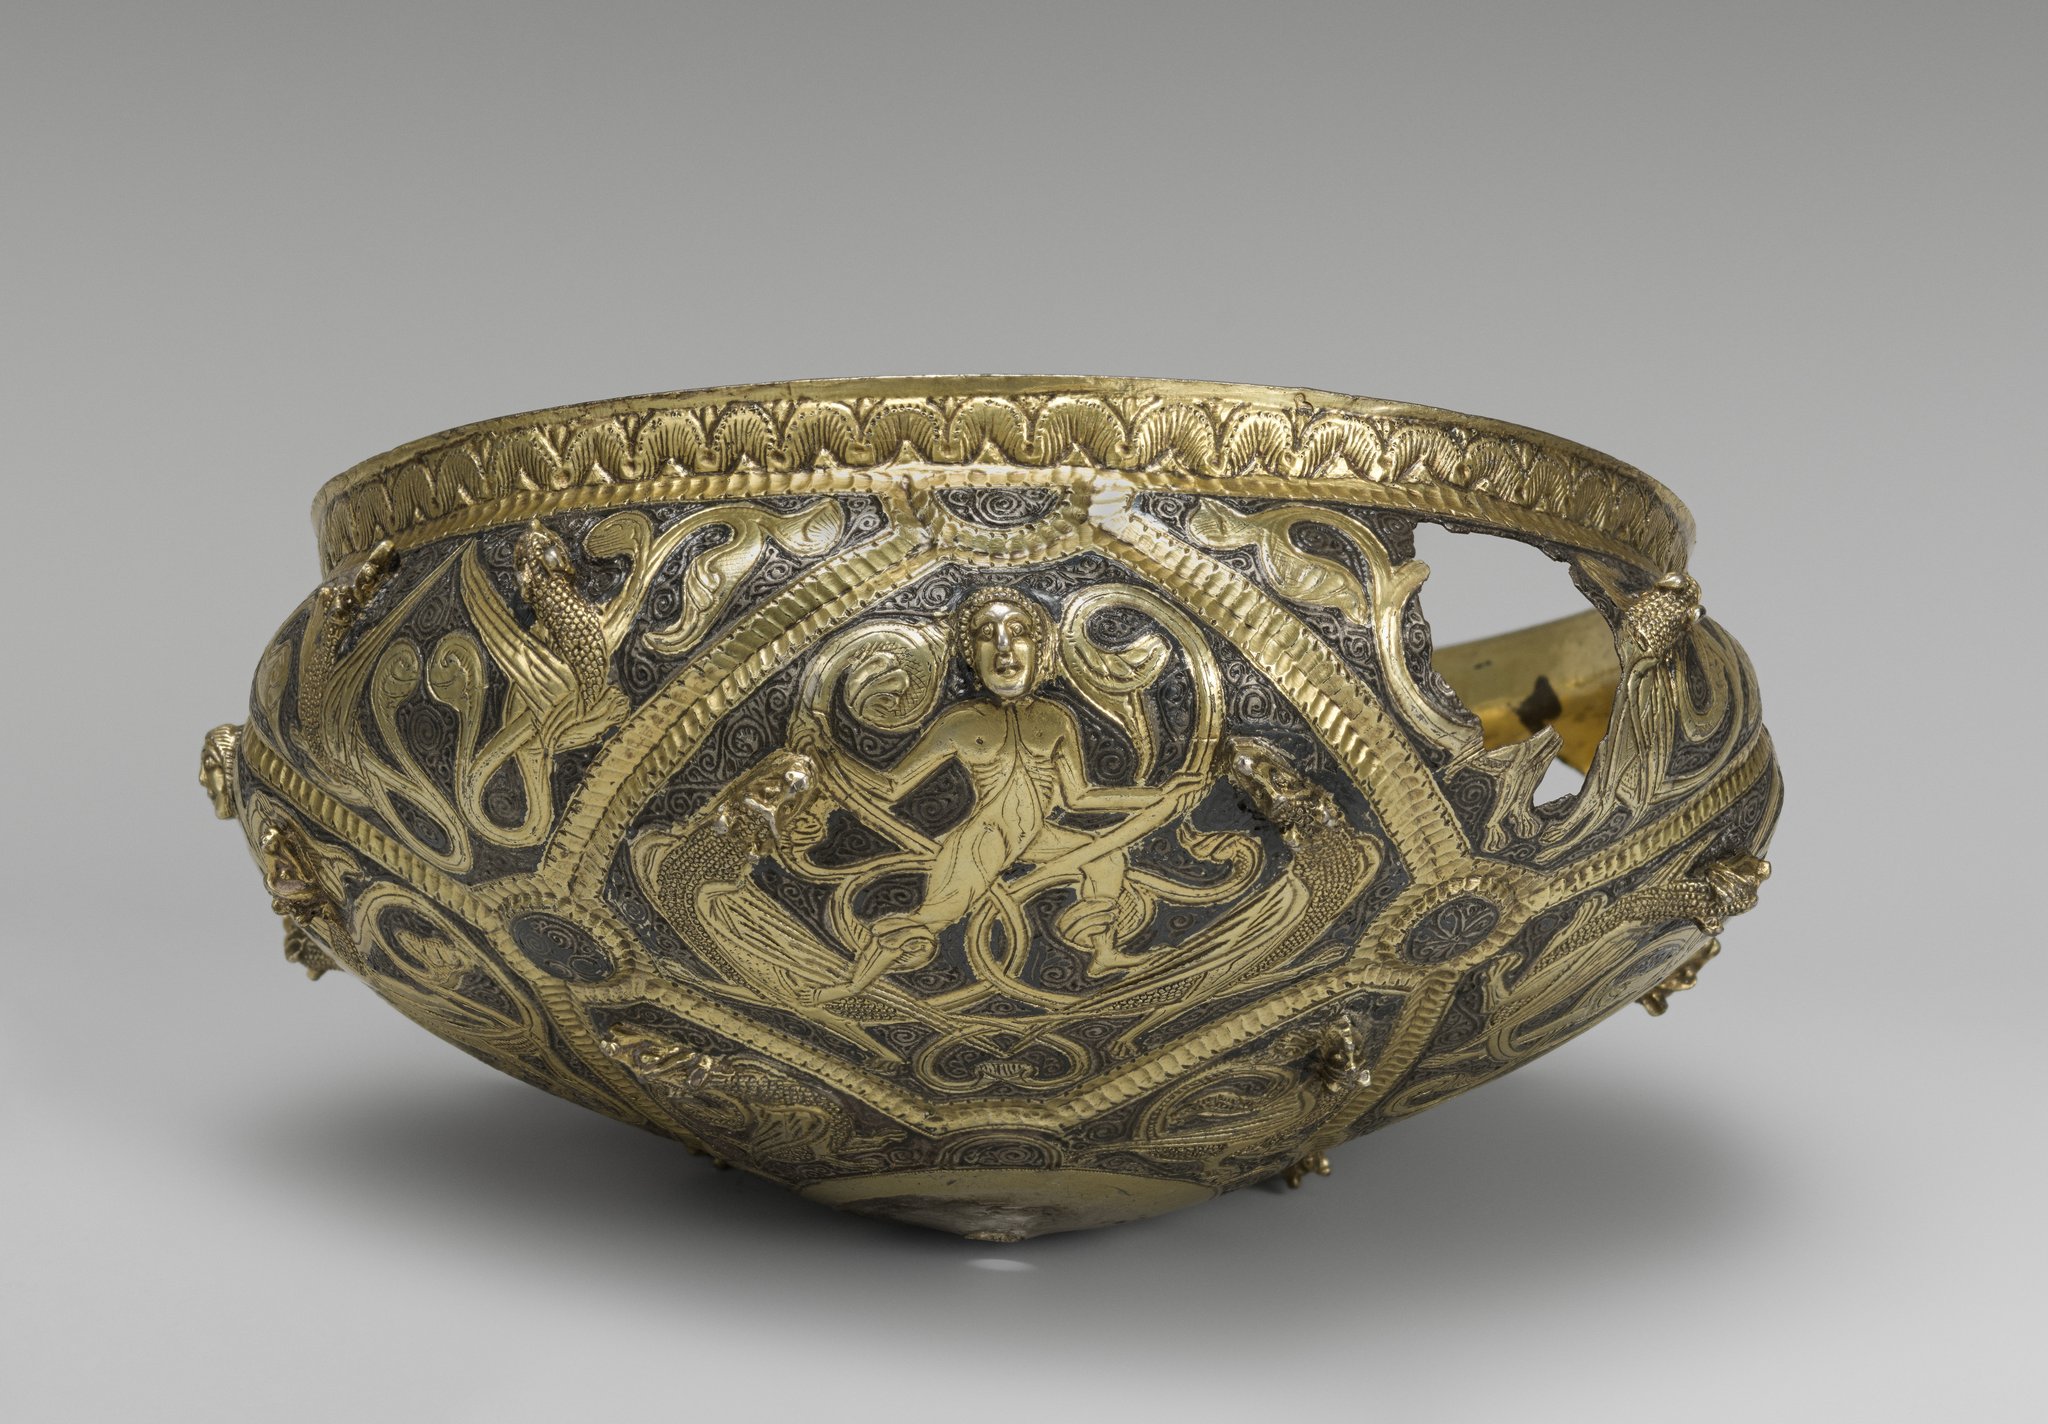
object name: bowl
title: Bowl of a Drinking Cup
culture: british or scandinavian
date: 1167-1200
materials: niello, silver, silver gilt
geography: england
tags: animals,birds,men